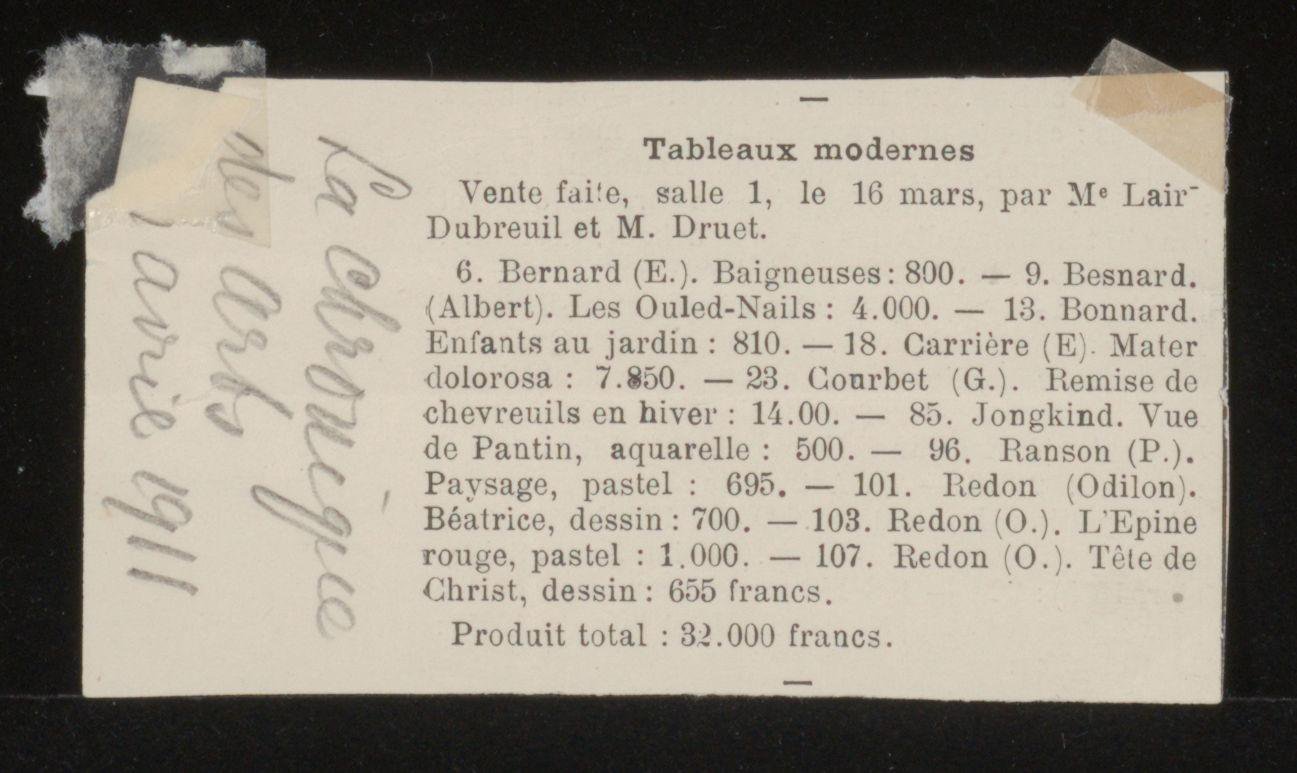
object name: newspaper clipping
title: Krantenknipsel uit La Chronique des Arts betreffende de verkoop van kunstwerken van Odilon Redon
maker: Anonymous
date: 1911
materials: paper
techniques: printing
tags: paris, painter, print maker, draughtsman, odilon redon, art trade, art shop, painting (including book-illumination, miniature-painting), money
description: Krantenknipsel behoort tot een album samengesteld door weduwe Françoise W.M. Barones van der Borch van Verwolde met afschriften van brieven met betrekking tot (de familie van) Odilon Redon. Het krantenknipsel werd bewaard op pagina 175.